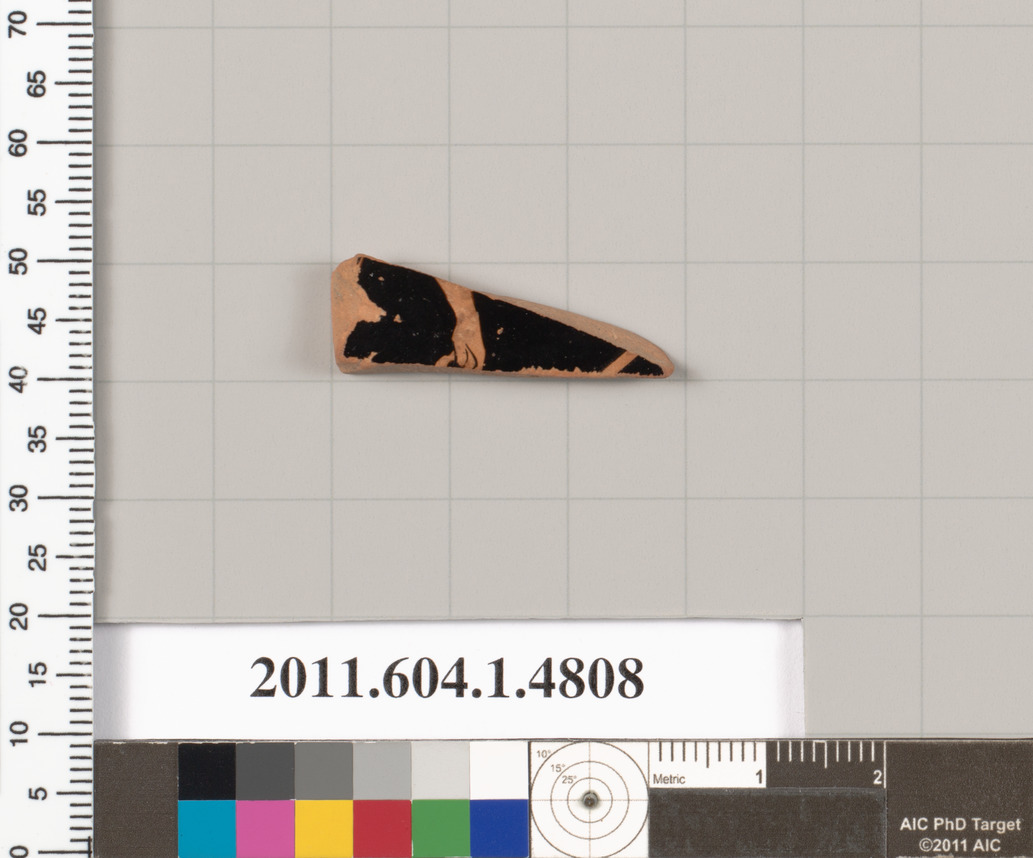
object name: kylix fragment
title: Terracotta fragment of a kylix (drinking cup)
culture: greek, attic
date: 490-470 BCE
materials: terracotta